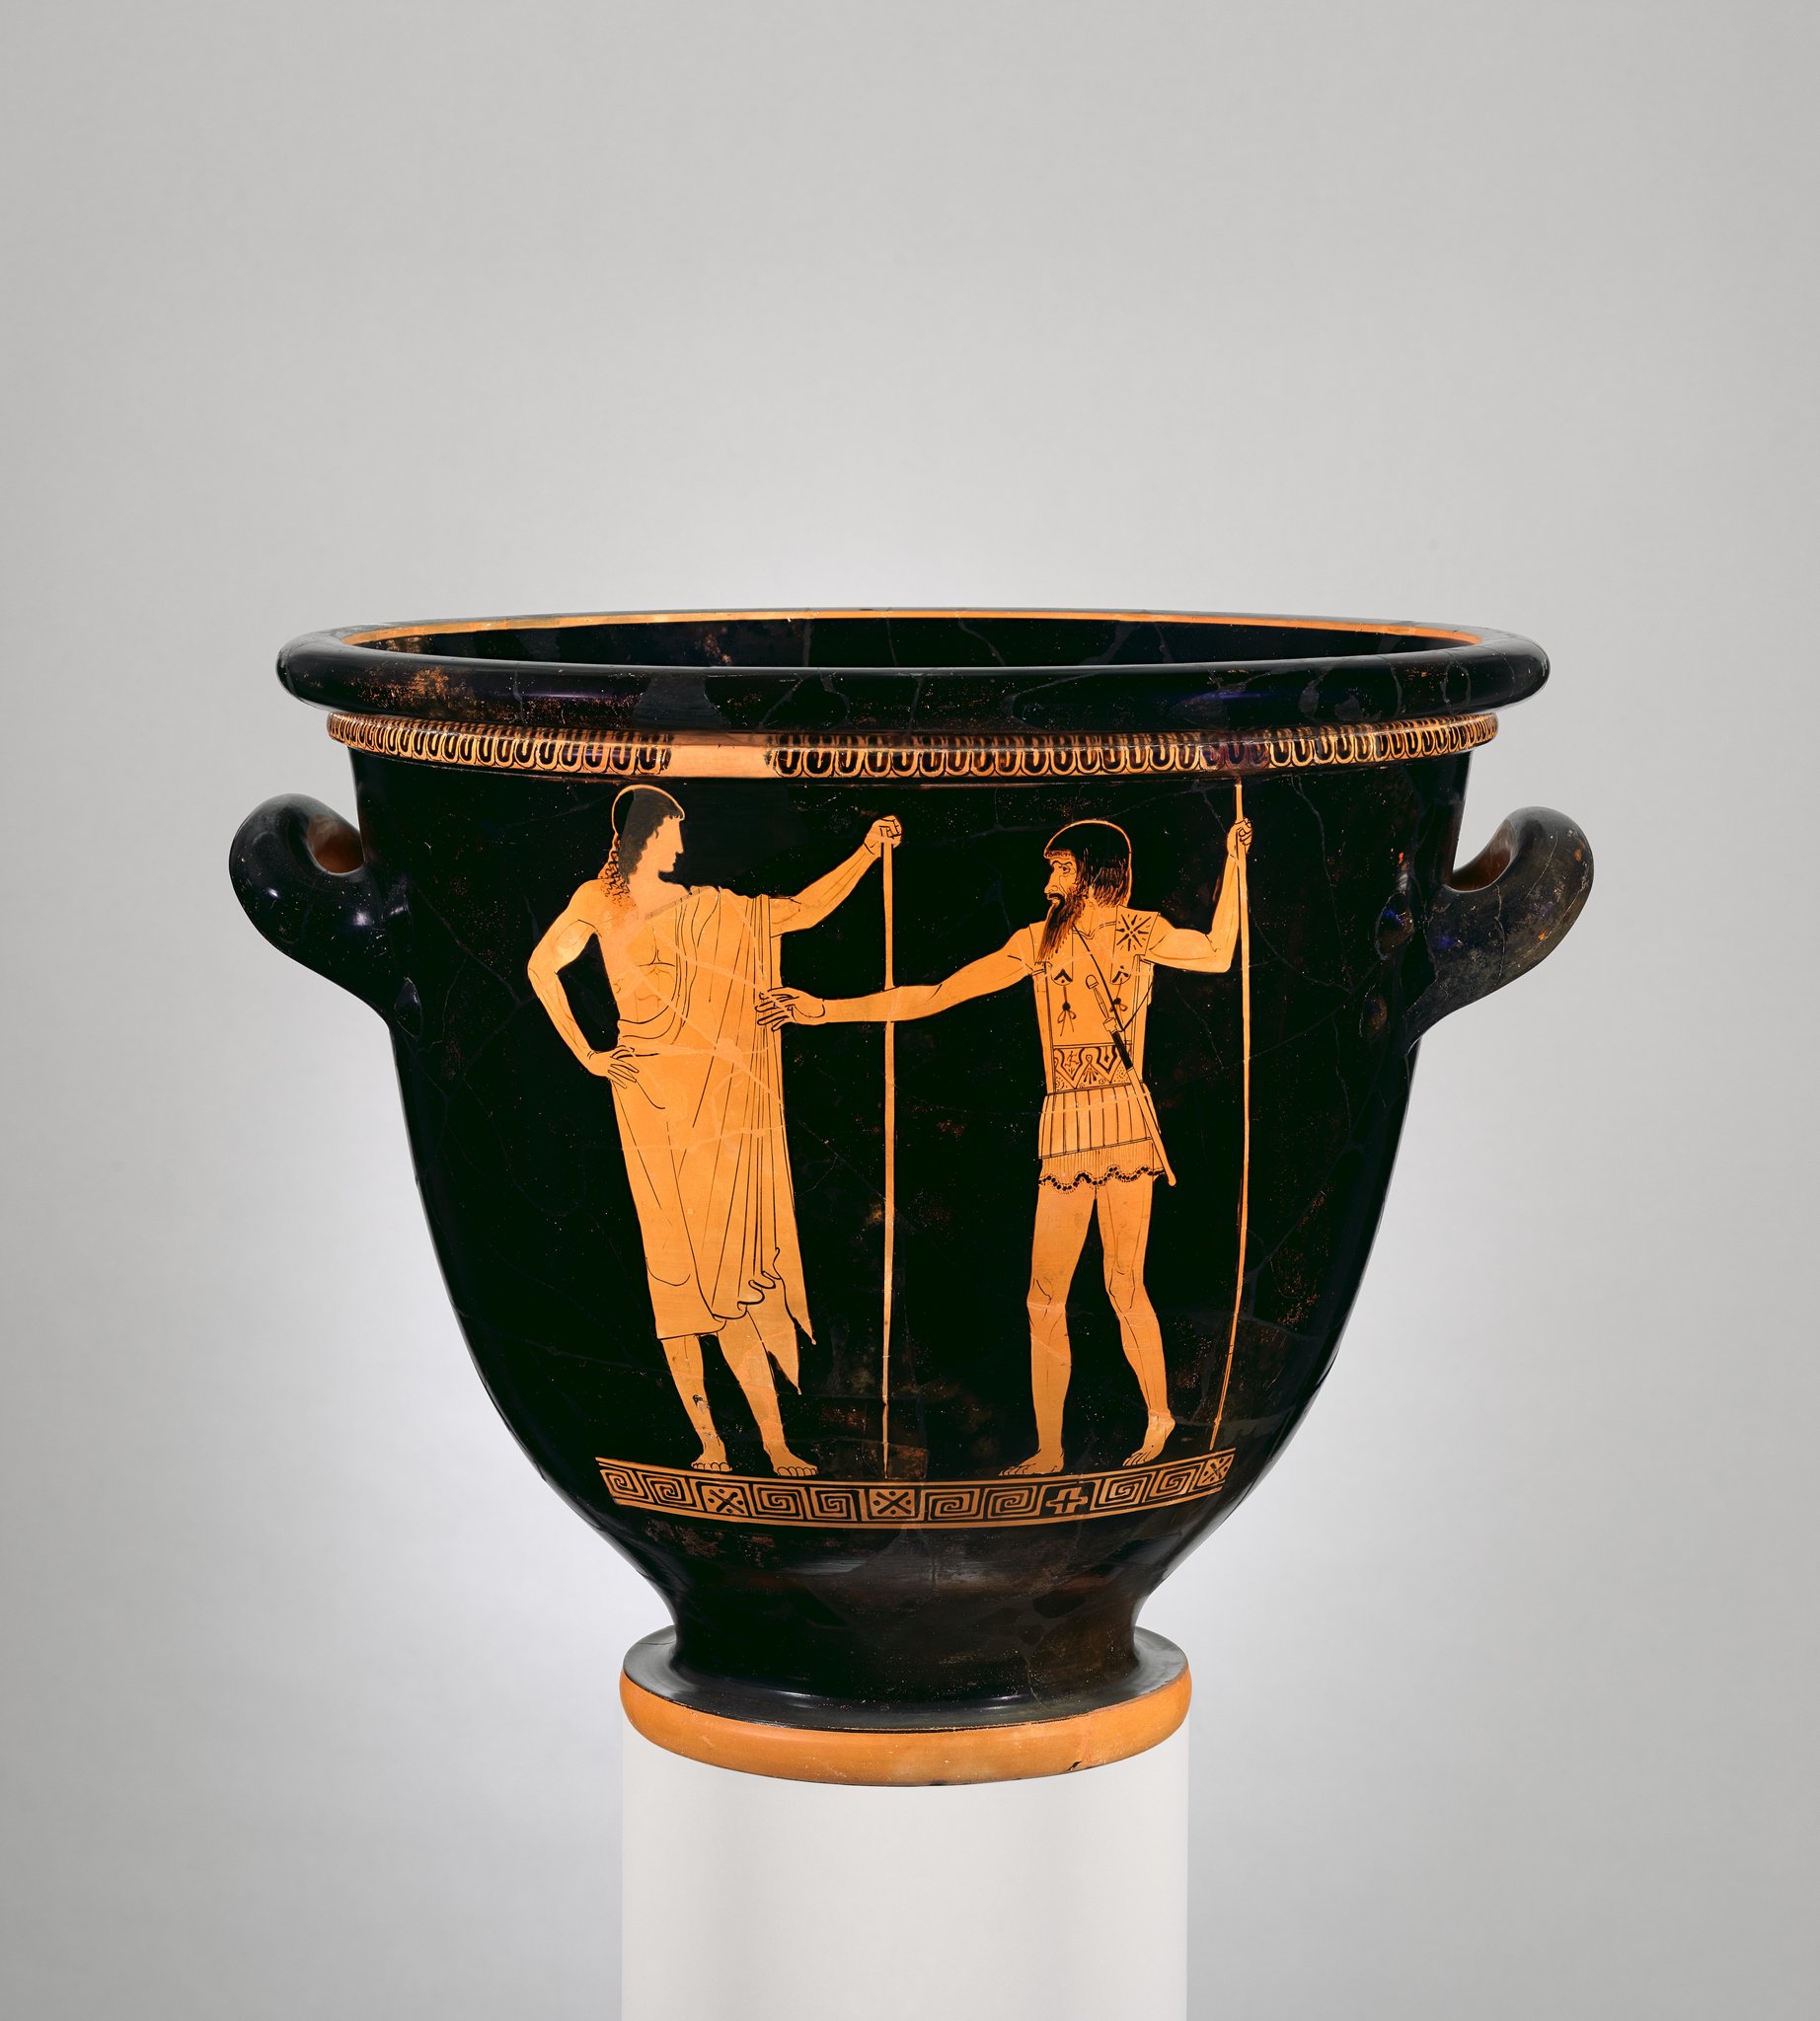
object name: bell krater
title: Terracotta bell-krater (bowl for mixing wine and water)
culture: greek, attic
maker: achilles painter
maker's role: artist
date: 460-450 BCE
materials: terracotta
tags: men,nike